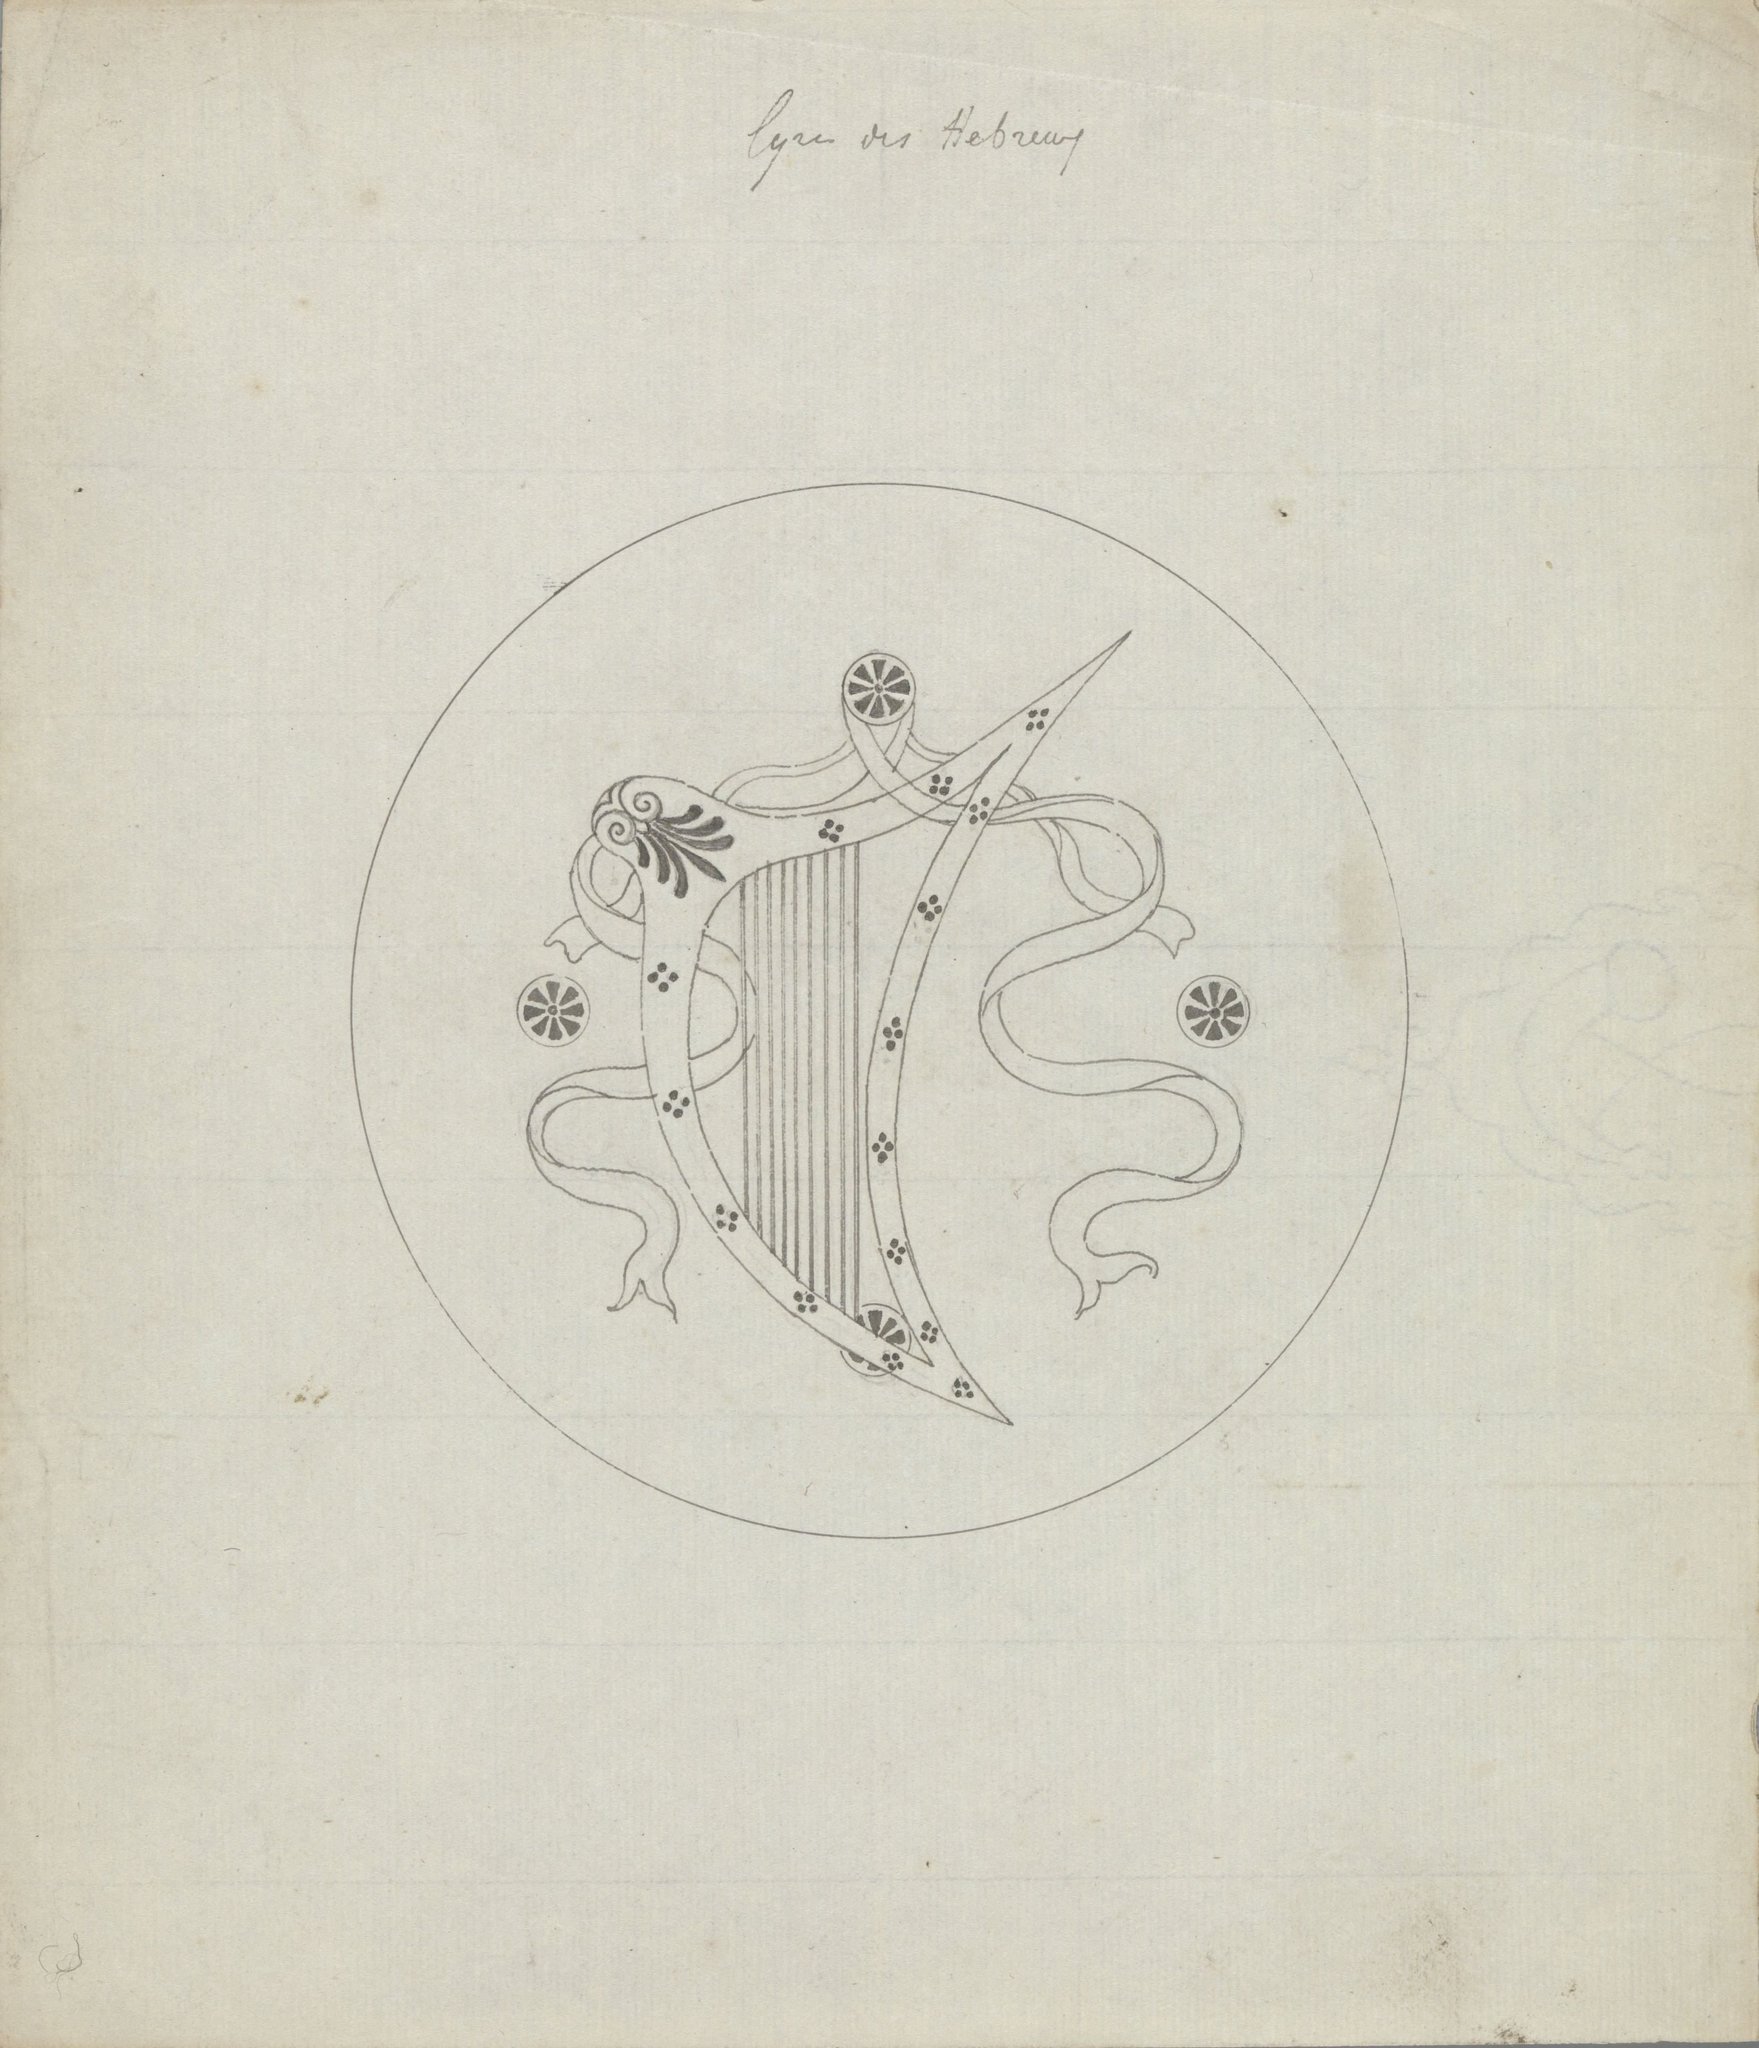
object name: design drawing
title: Ontwerp voor marqueterie van aan linten opgehangen muziekinstrument(en) in rond medaillon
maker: pierre félix van doren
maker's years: 1797-1856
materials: graphite, ink, paper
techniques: pen in black ink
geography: brussels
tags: trophy, i.e.: decorative arrangement of symbolic or typical objects ~ ornament, lyre, cithara, psaltery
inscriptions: inscription: ‘lyre des Hebreux’, watermark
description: Een van 103 ontwerpen voor marqueterie van aan linten opgehangen muziekinstrumenten in ronde medaillons, bestemd voor de set stoelen gemaakt door Van Doren voor de grote zaal van het Paleis van de Prins van Oranje in Brussel in 1828.